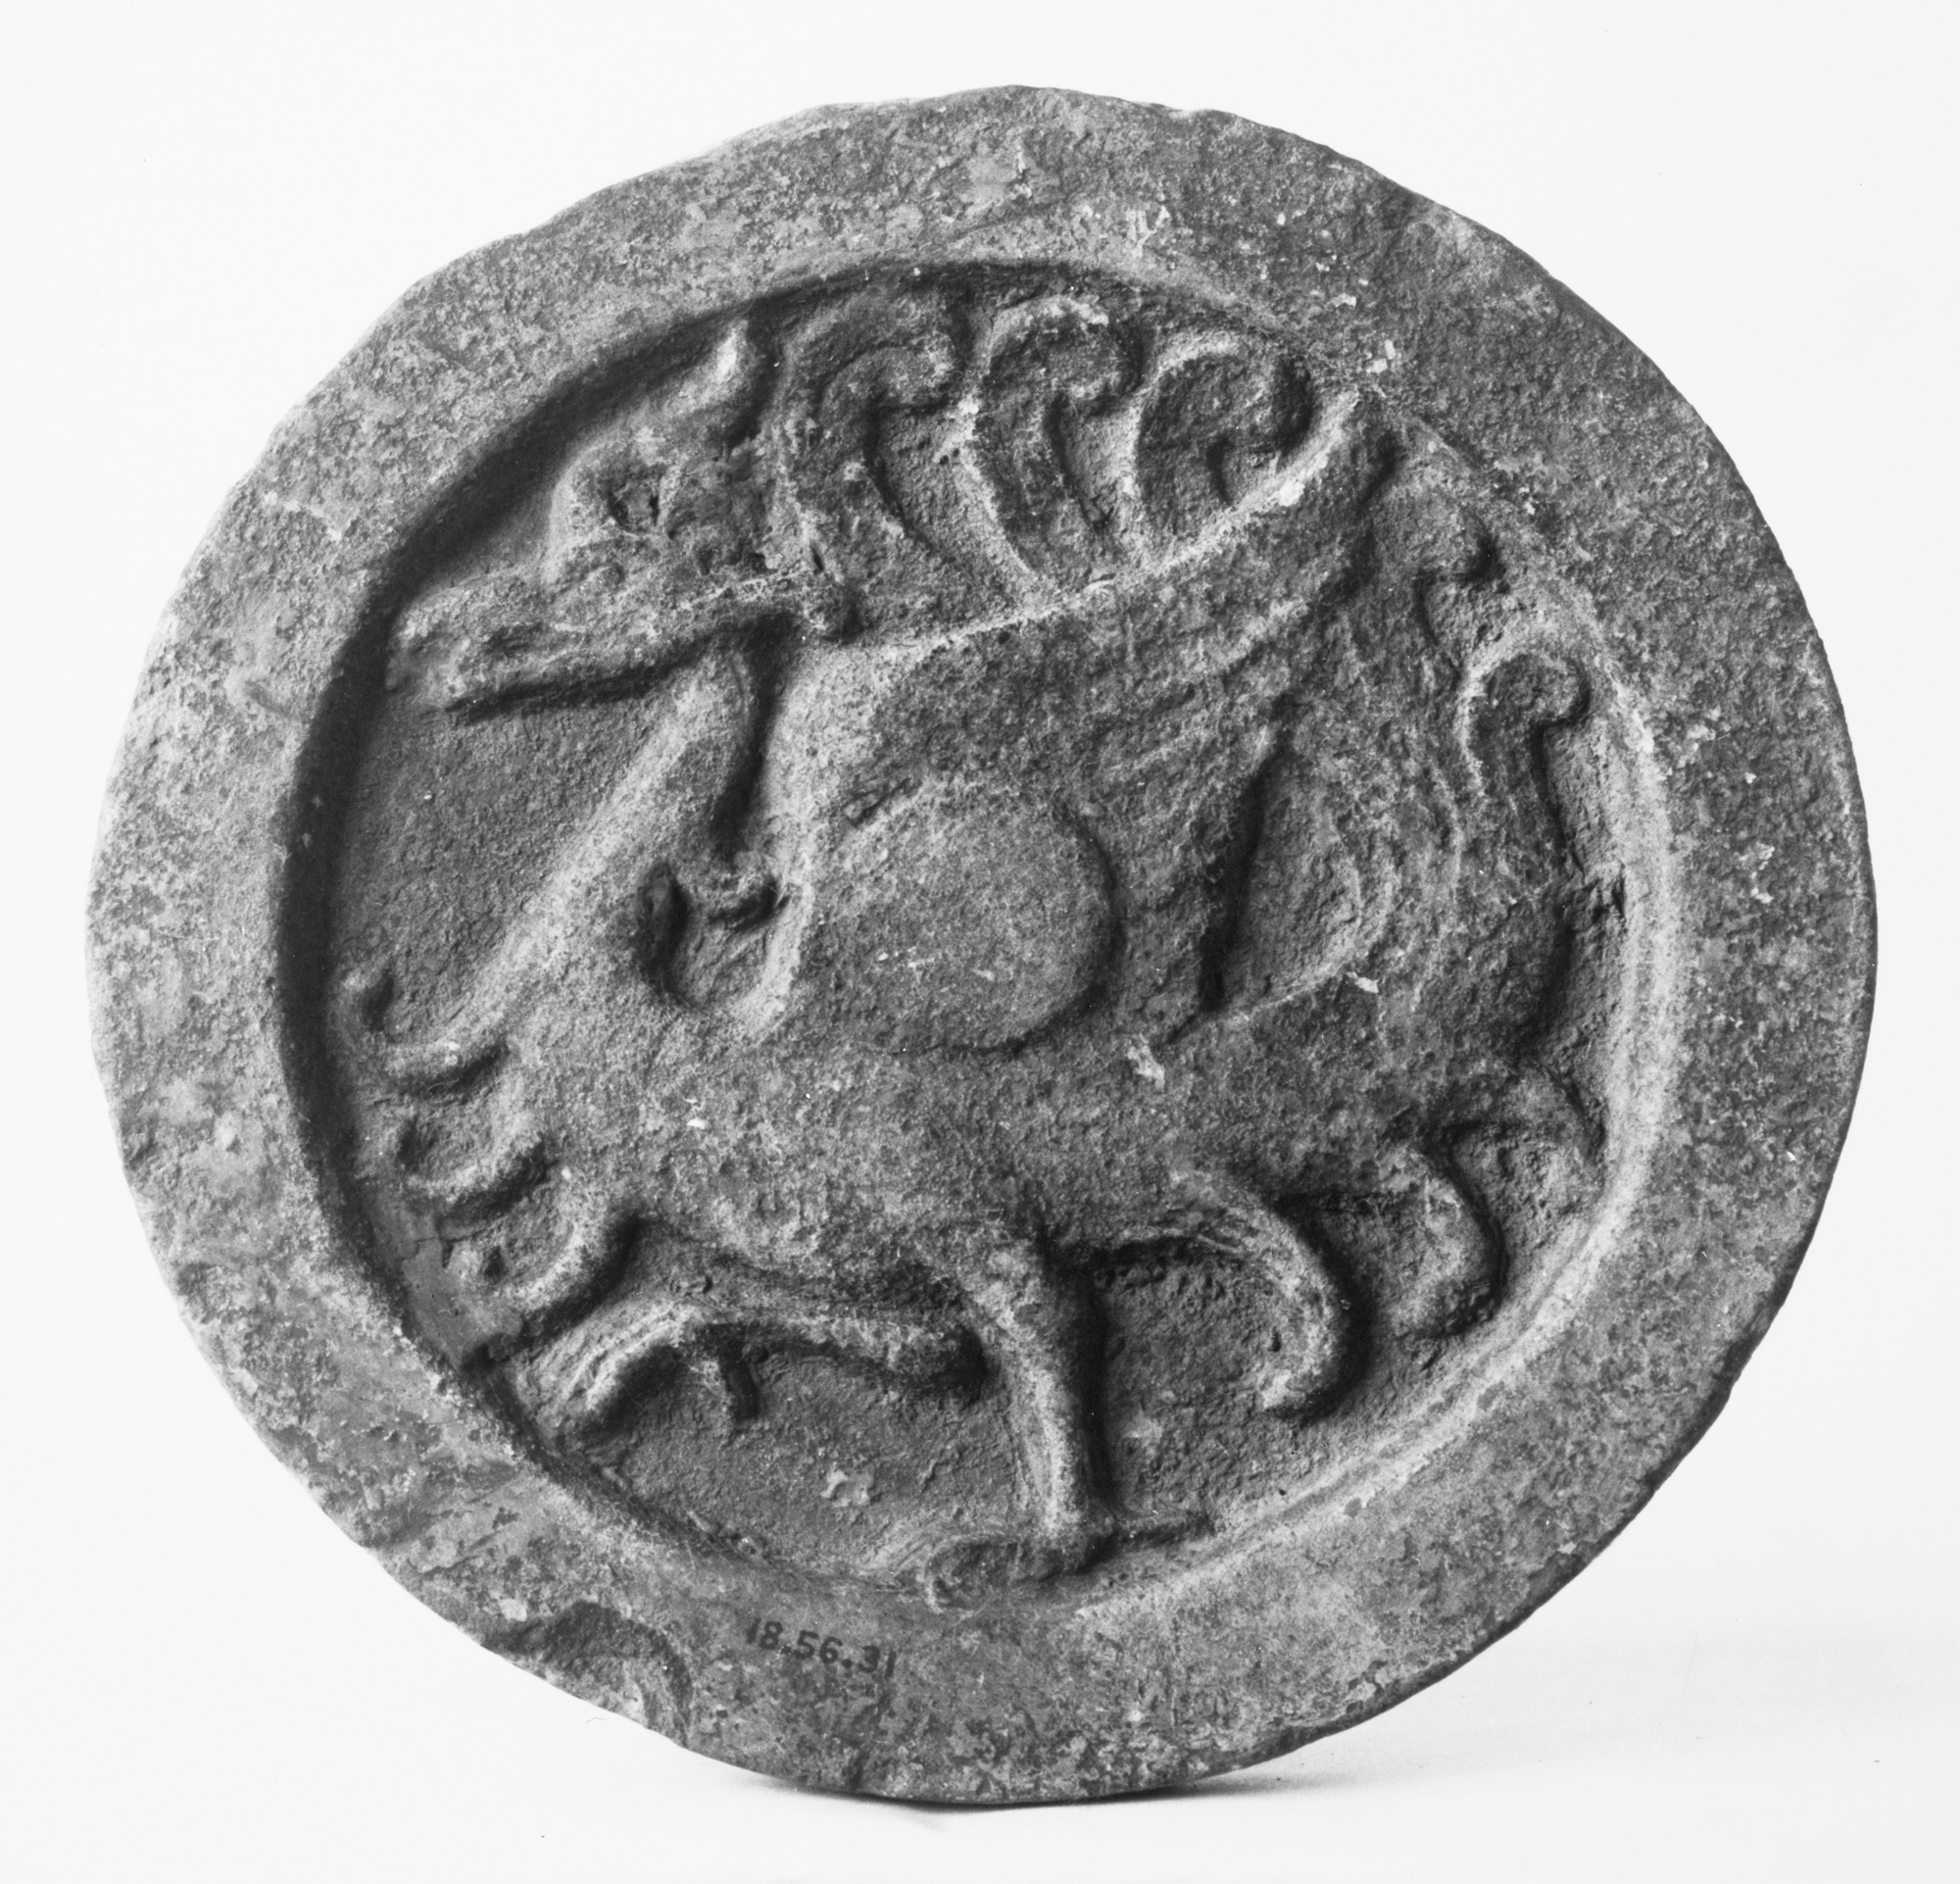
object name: roof tile end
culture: chinese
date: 206 BCE-9 CE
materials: earthenware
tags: birds